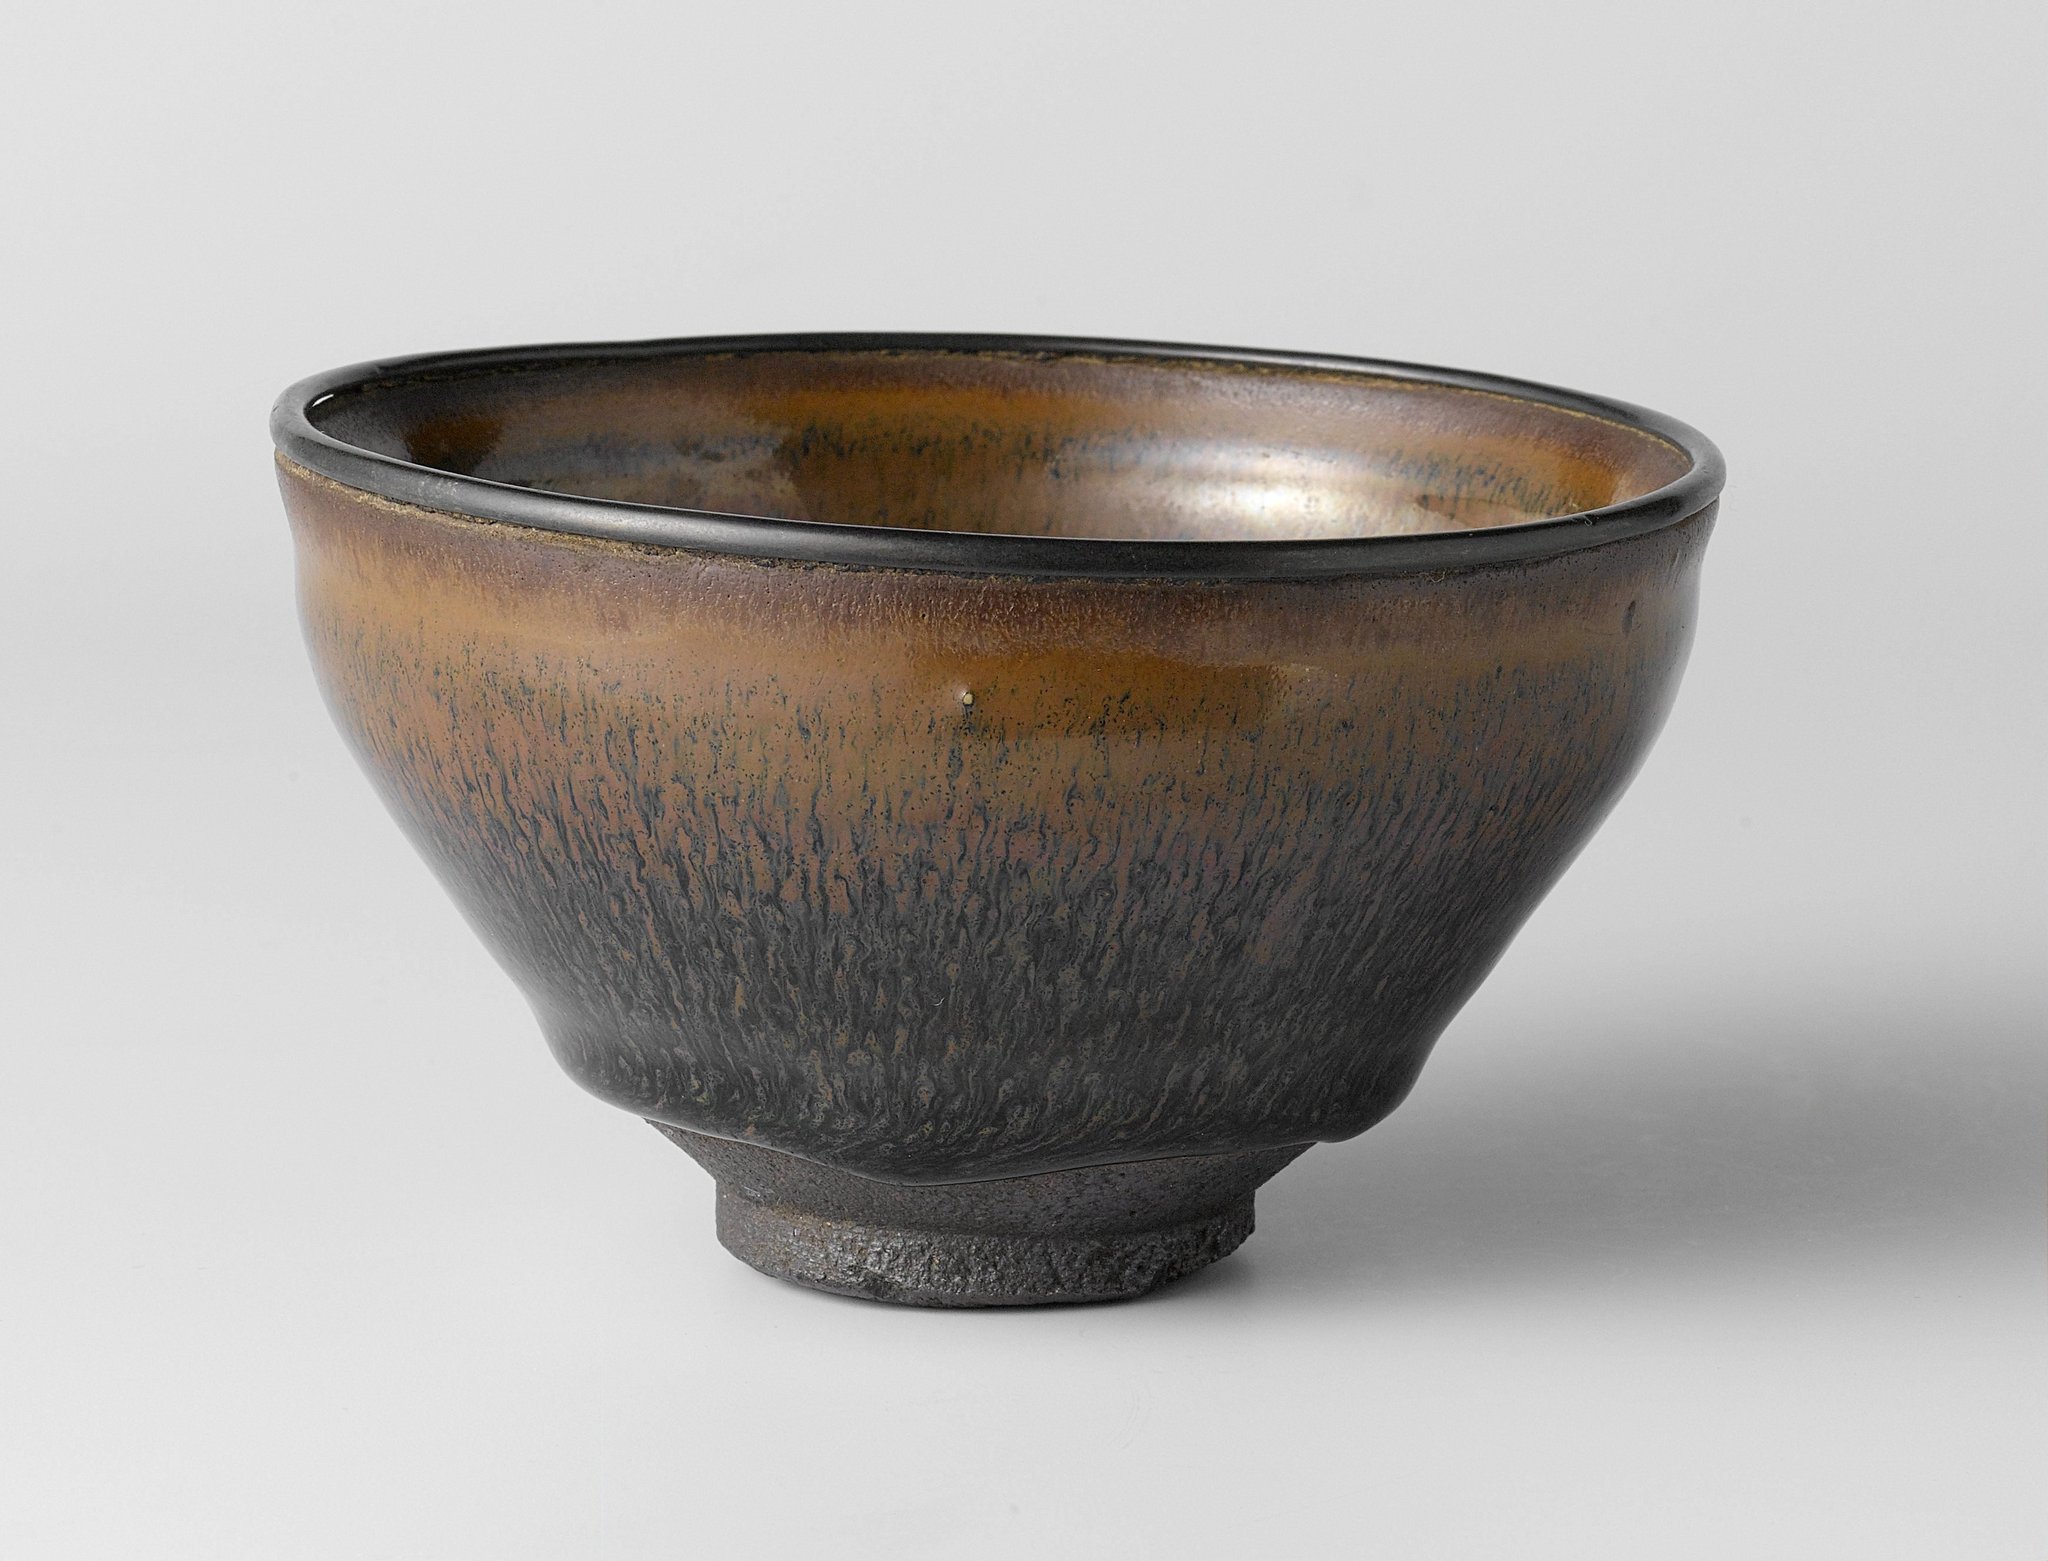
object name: tea bowl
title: Bowl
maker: Anonymous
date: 1100-1299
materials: glaze, metal, stoneware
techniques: firing, turning, vitrification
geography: china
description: Stoneware with black or black-brown glaze was popular among the lower middle class, especially for utilitarian items designed for everyday use. This type of stoneware was made in Fujian province. The kilns there produced a deep black stoneware through the addition of iron-rich glazes. This bowl has a thick glaze with a fine striped pattern, aptly described as the ‘hare’s fur.’